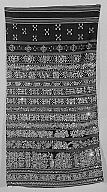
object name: skirt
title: Woman's Ceremonial Skirt (Tapis)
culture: lampung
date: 1801-1900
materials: cotton, gold, metal, silk, thread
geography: indonesia